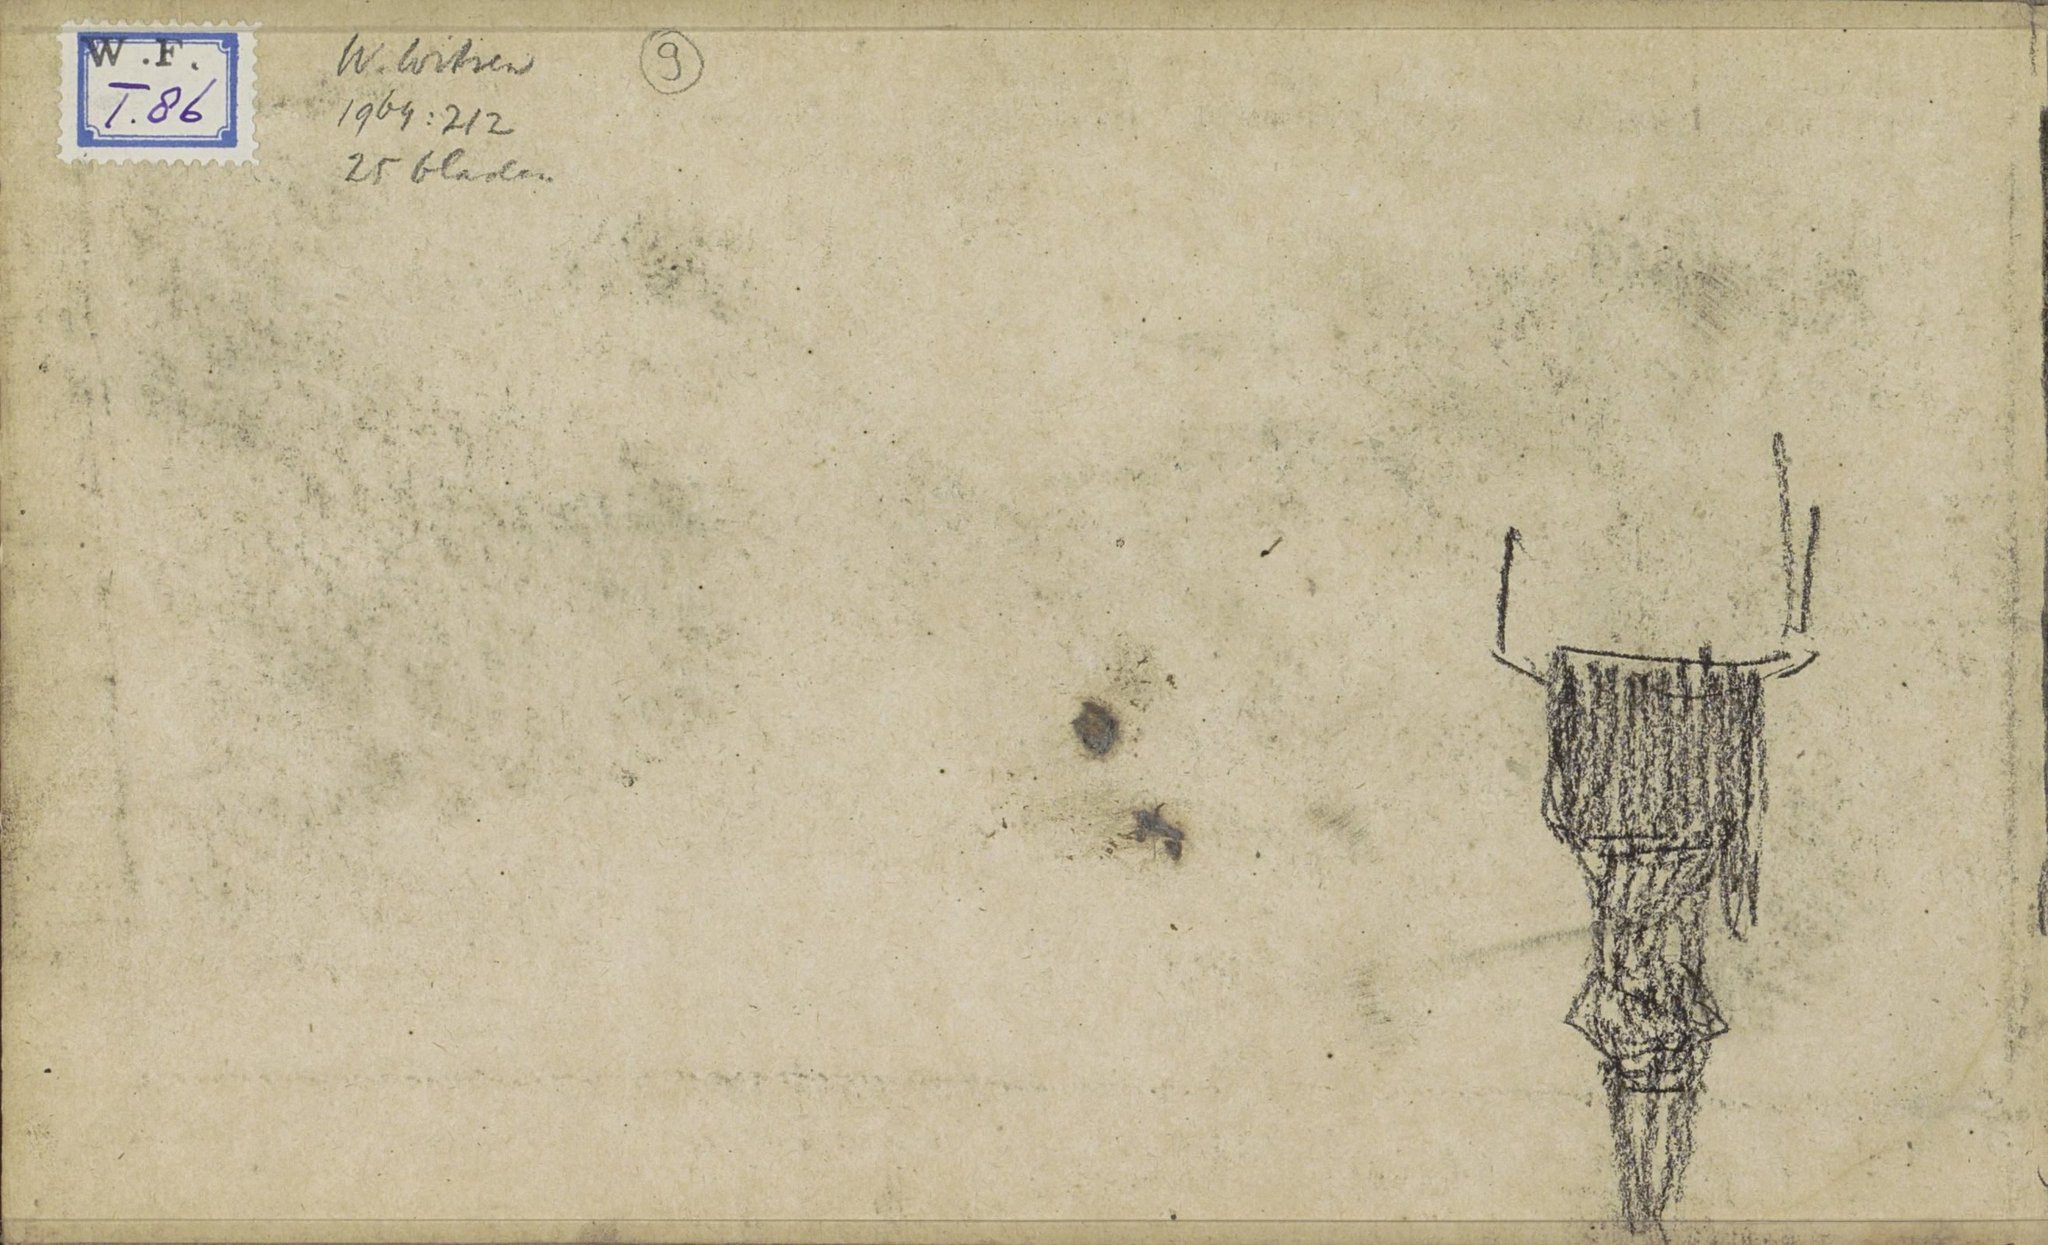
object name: sketchbook leaf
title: Toren, mogelijk de Montelbaanstoren te Amsterdam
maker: willem witsen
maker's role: draughtsman, painter, print maker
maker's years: 1860-1923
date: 1887-1897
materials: chalk, paper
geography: amsterdam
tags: tower (of house or building)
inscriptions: annotation: ‘W.F./ T. 86’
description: Schutblad A, voorste schutblad, uit een schetsboek met 25 bladen.